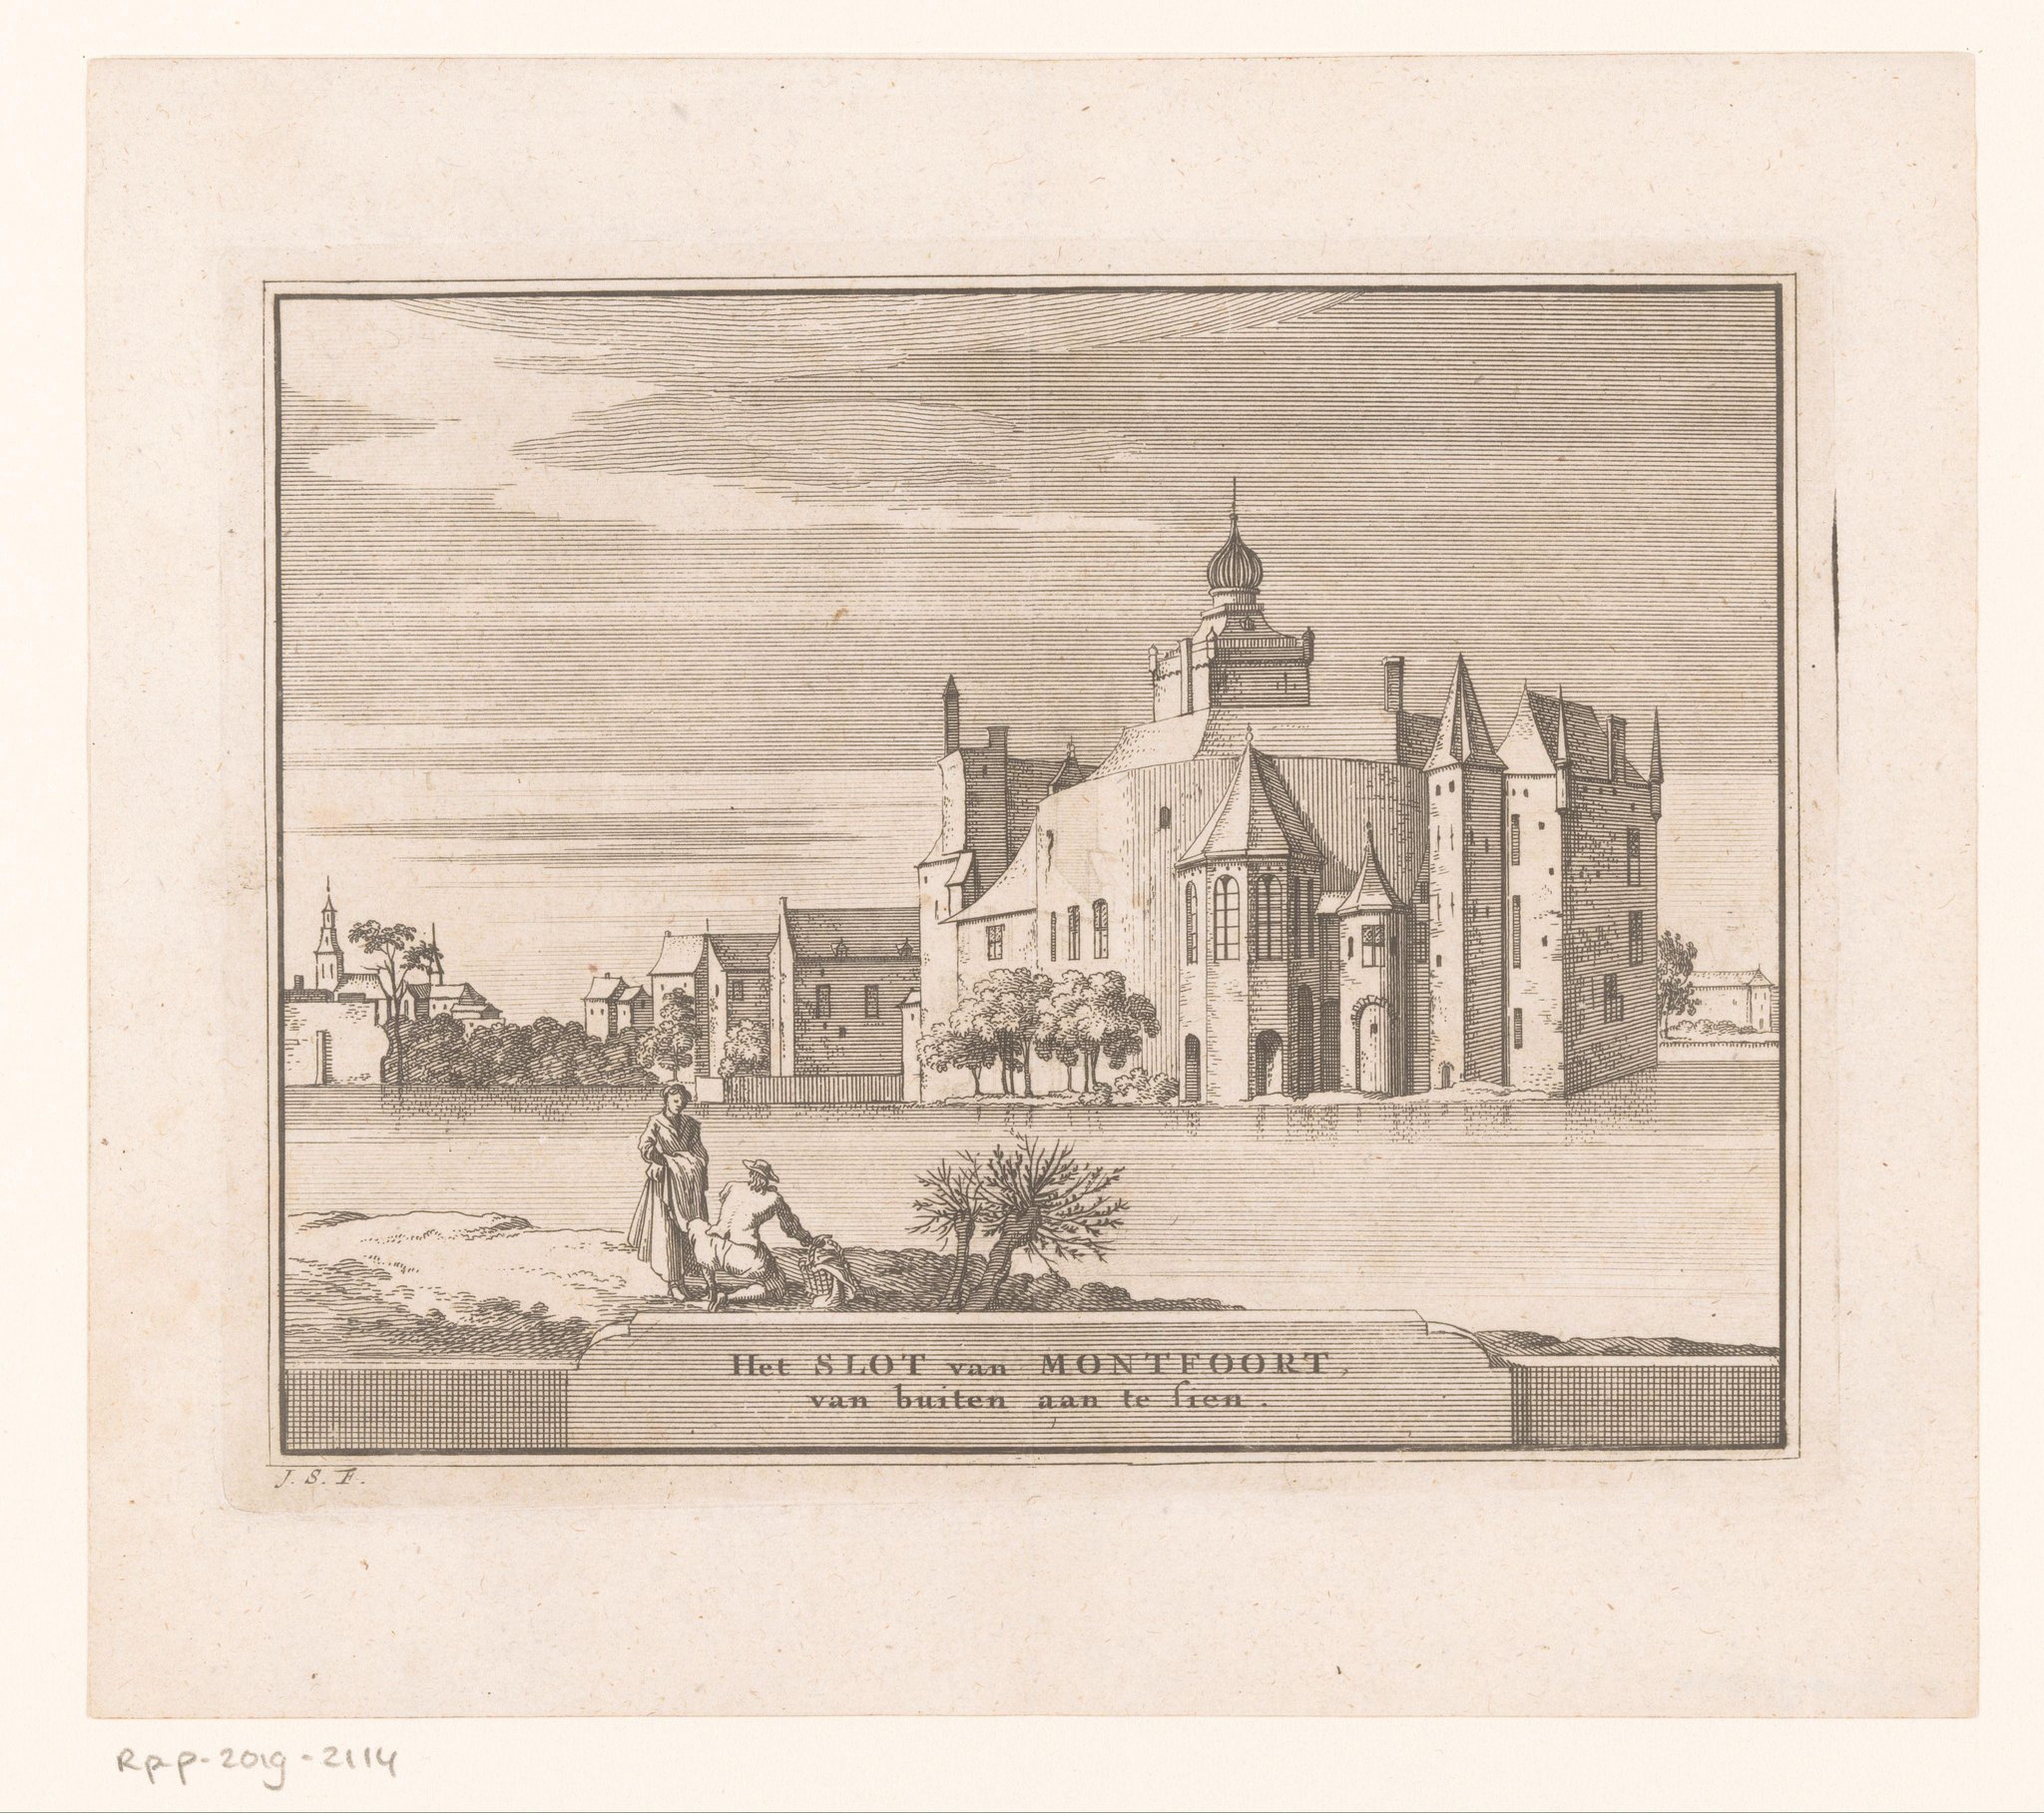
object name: print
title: Gezicht op het kasteel van Montfoort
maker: jacobus schijnvoet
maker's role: draughtsman, print maker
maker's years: 1685-1743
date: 1711-1774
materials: paper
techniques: etching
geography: amsterdam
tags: castle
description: Prent opgenomen in: Smids, Ludolph. Schatkamer der Nederlandsse[!] oudheden; of Woordenboek, behelsende Nederlands steden, Amsterdam: Pieter de Coup, 1711. Verscheen tevens in de heruitgave van voorgenoemd werk in 1737 en 1774. In 1721 verscheen er een uitgave met alleen de prenten: Nederlandsche oudheden, bestaande in zestig verbeeldingen (...) gelegen in Holland, 't Sticht van Utrecht en Gelderland enz. Amsterdam: Hendrik Bosch, 1721.